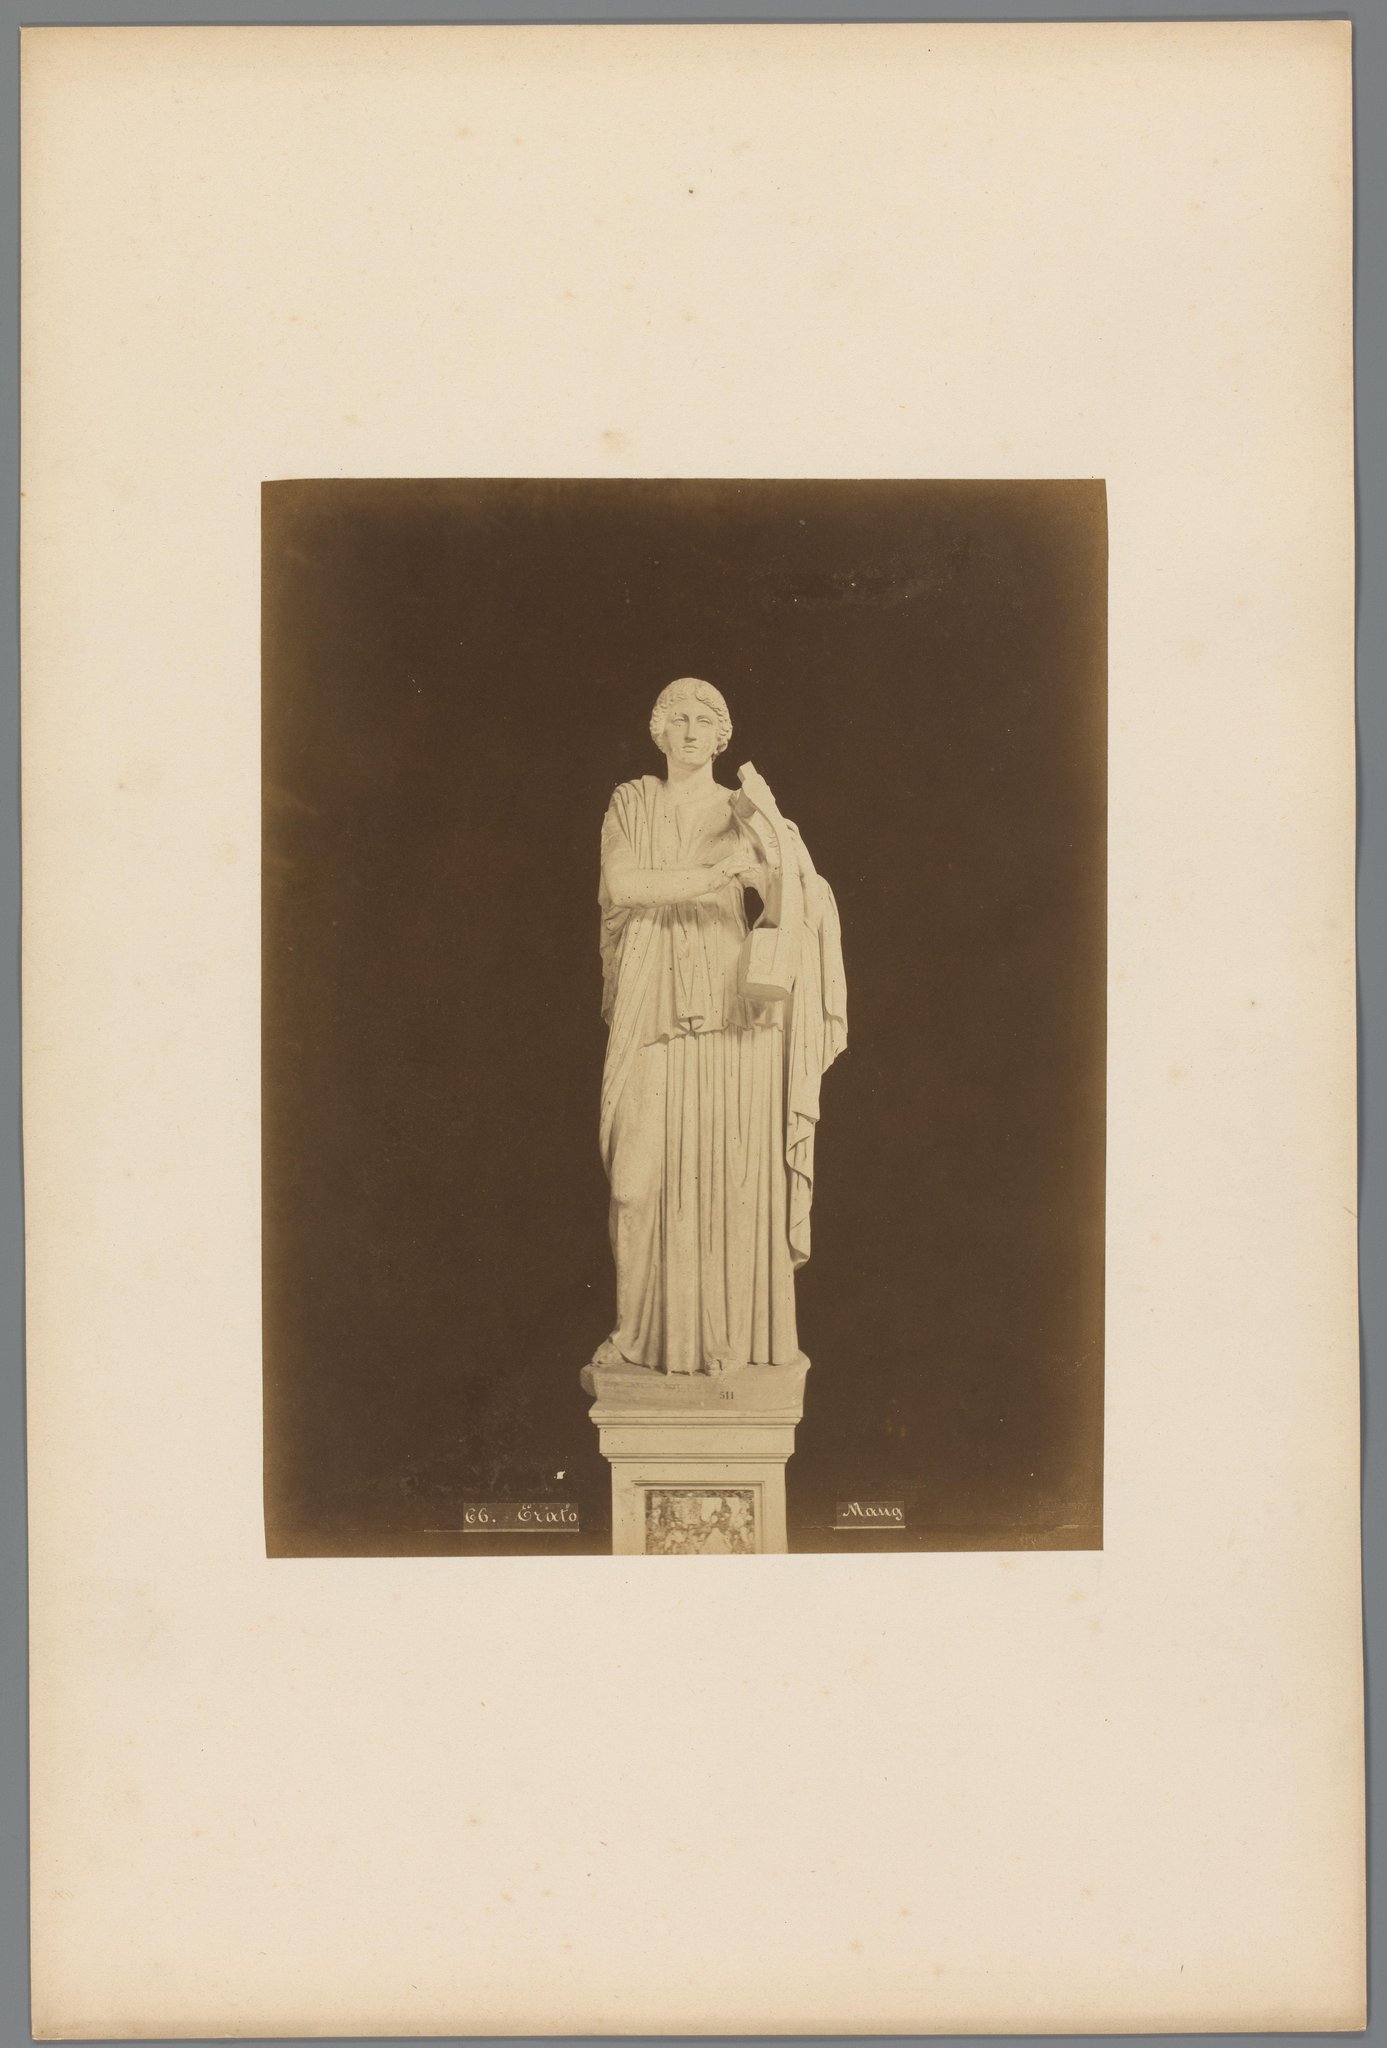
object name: photograph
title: Erato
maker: michèle mang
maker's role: fotograaf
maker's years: 1840-1909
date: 1863-1887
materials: cardboard, paper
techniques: albumen print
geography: vatican city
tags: piece of sculpture, reproduction of a piece of sculpture, erato (one of the muses); 'erato' (ripa)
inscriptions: number: ‘66.’